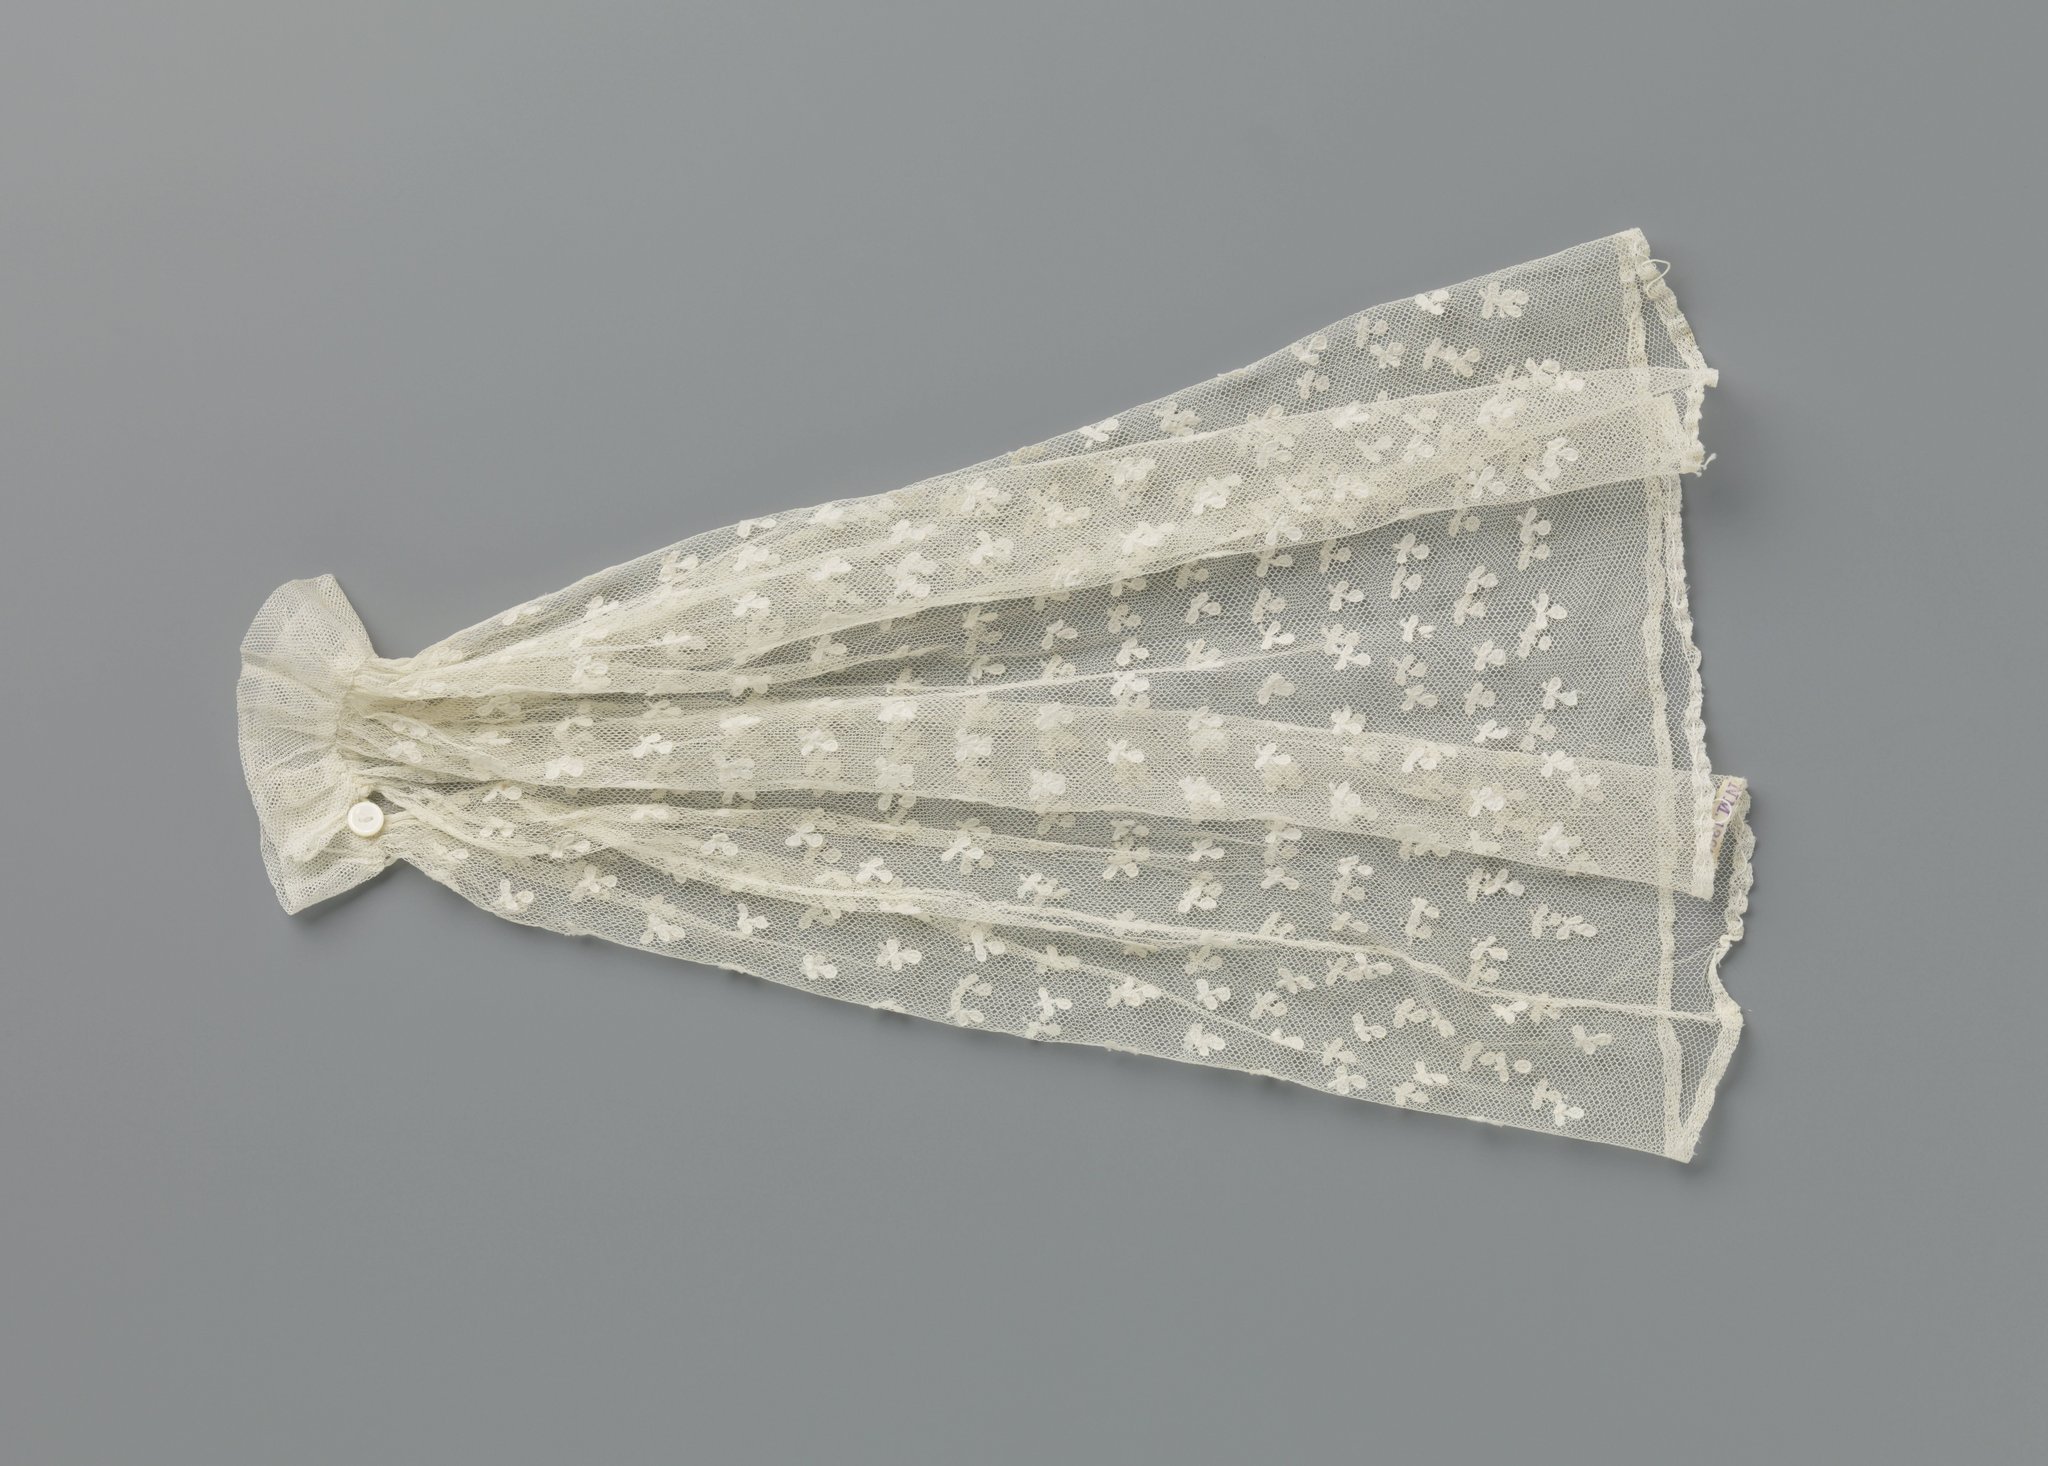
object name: womenswear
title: Ondermouw van applicatiekant met strooipatroon van ovaal bloempje op steeltje met twee blaadjes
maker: Anonymous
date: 1850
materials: textile, cotton, mother of pearl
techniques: lace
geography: netherlands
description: Ondermouw van naturelkleurige applicatiekant: batist geappliceerd op machinale tule. Wijd kokervormig model, sterk gerimpeld bij de pols waardoor het nauw sluit. Een apart gemaakt manchet van machinale tule is gerimpeld aan de mouw gezet. De onversierde manchet kan worden gesloten met een knoop. Op de mouw staat een strooipatroon van kleine ovale bloempjes, op een steeltje met twee blaadjes. De opening van de mouw is afgewerkt met een iets gerimpeld zoompje.